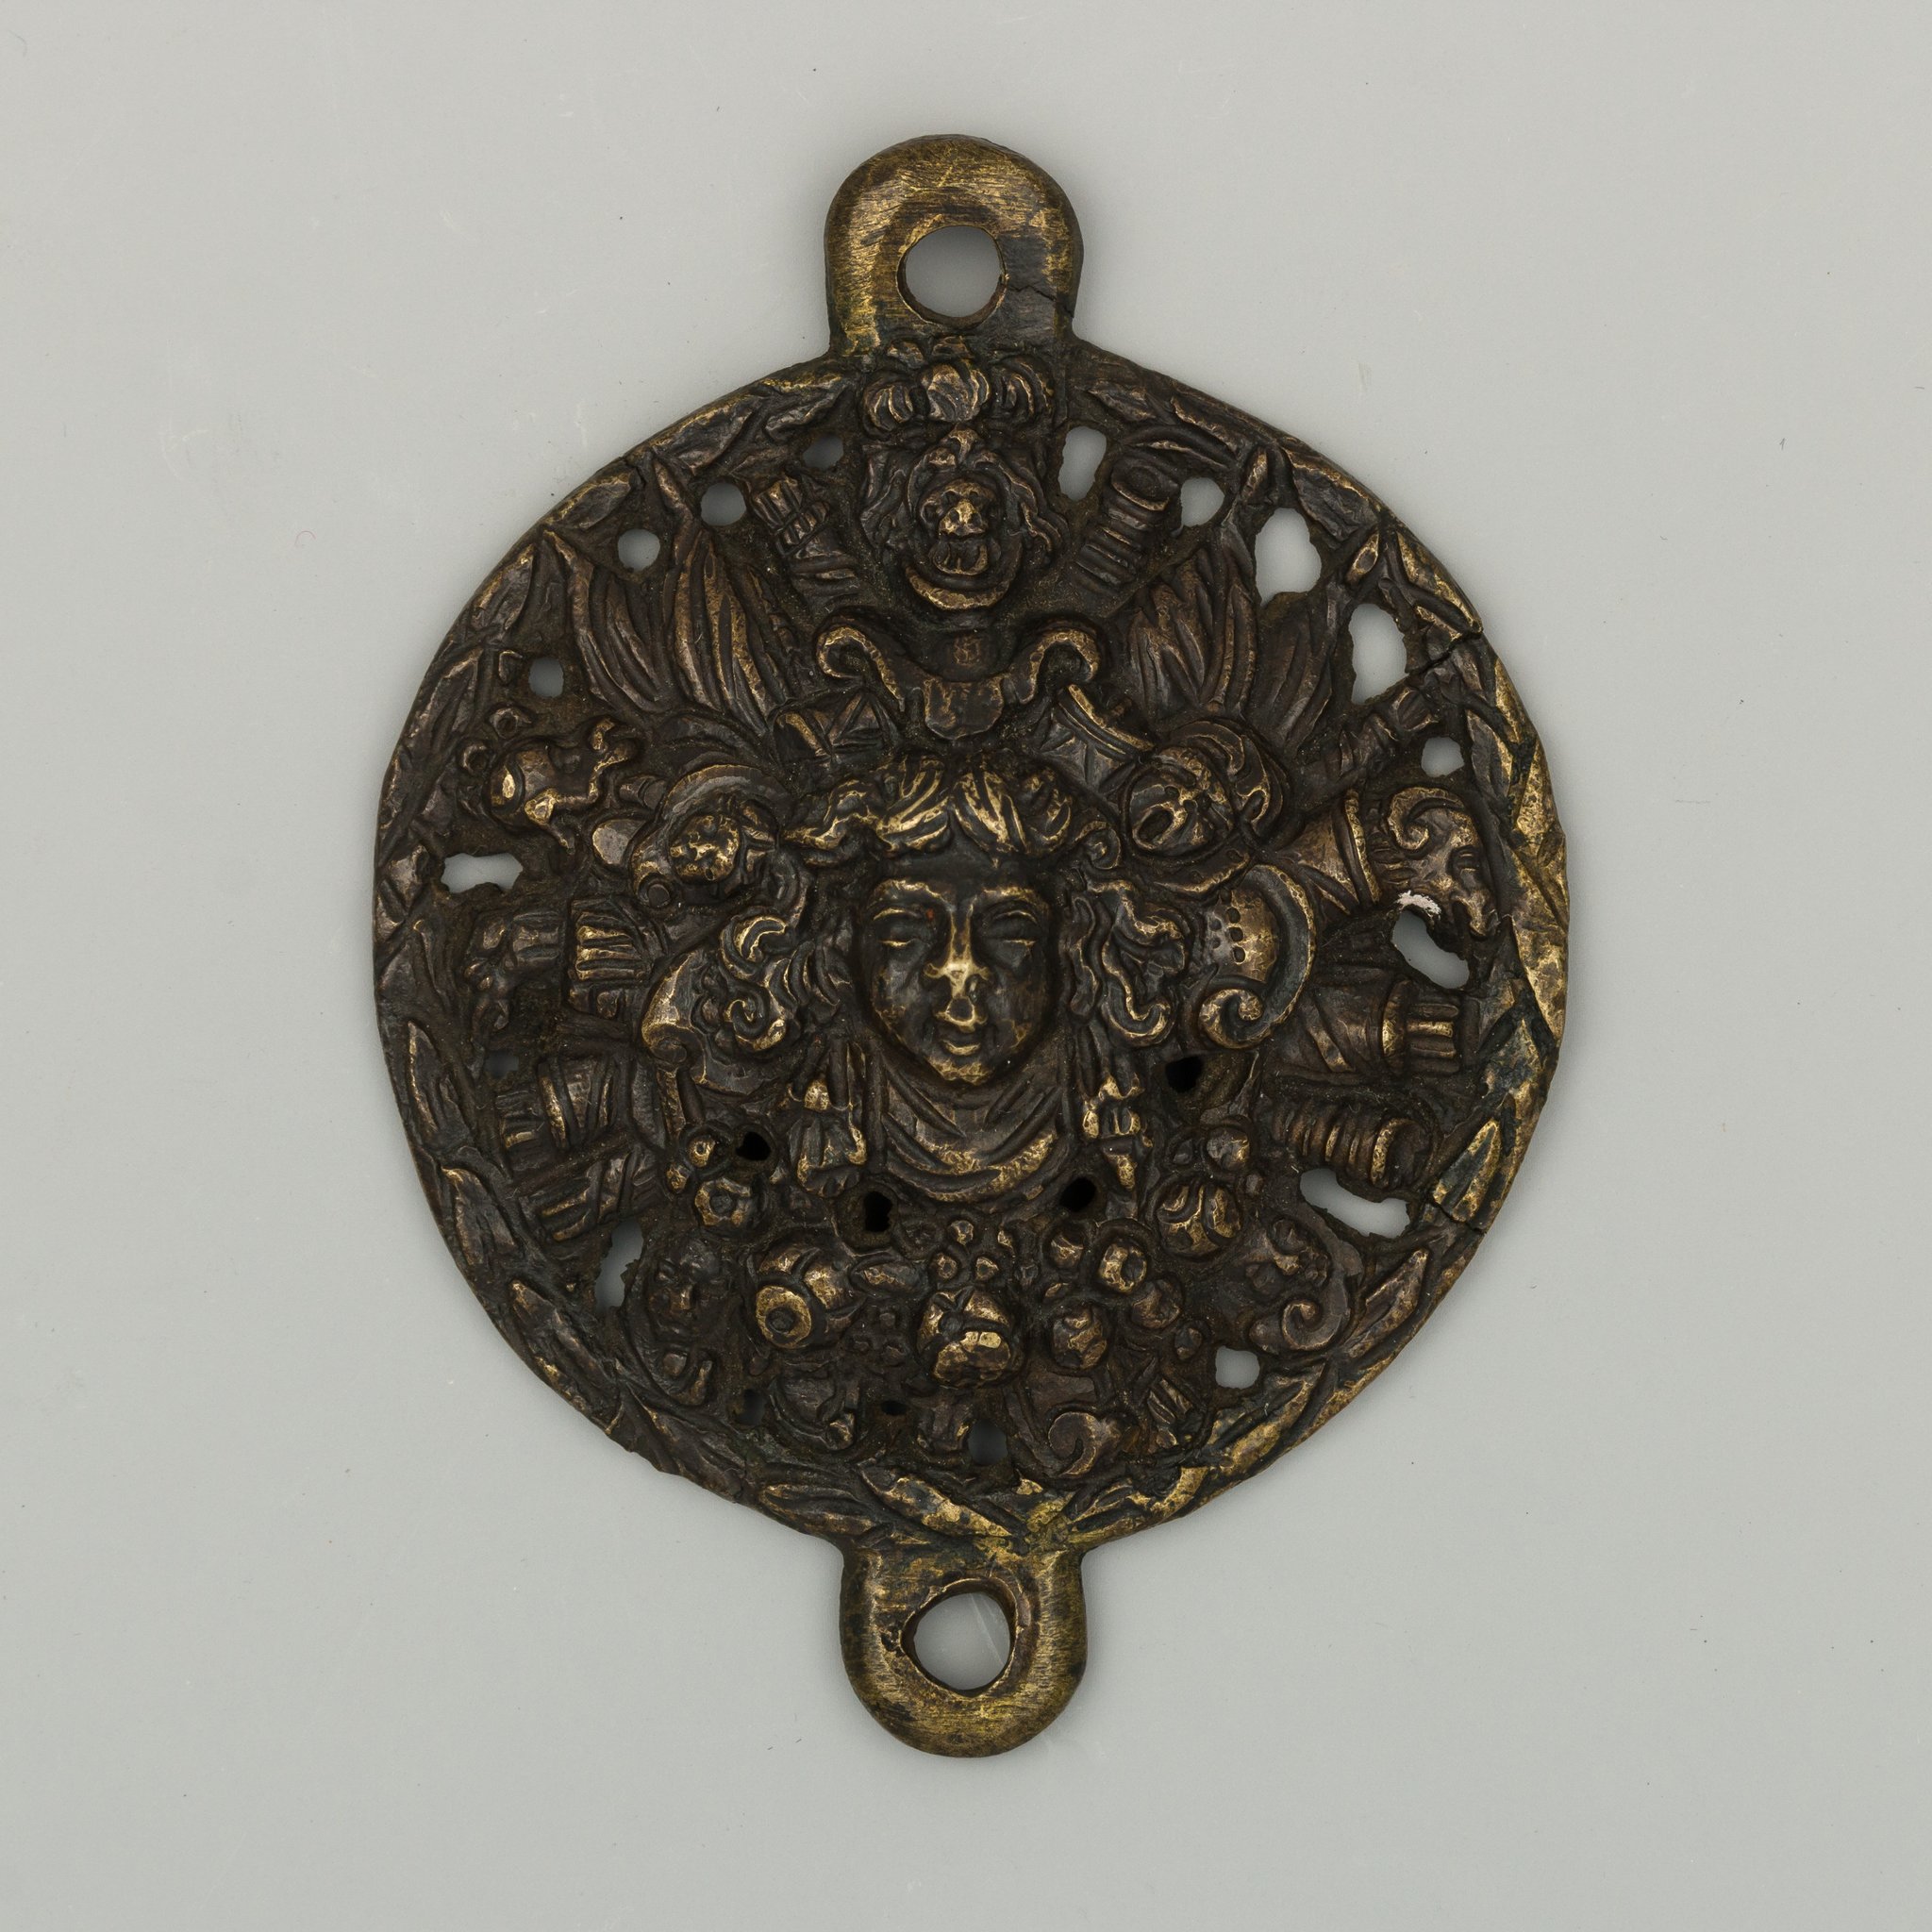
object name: bit bos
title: Bit Boss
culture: french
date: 1670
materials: copper alloy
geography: france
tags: apollo